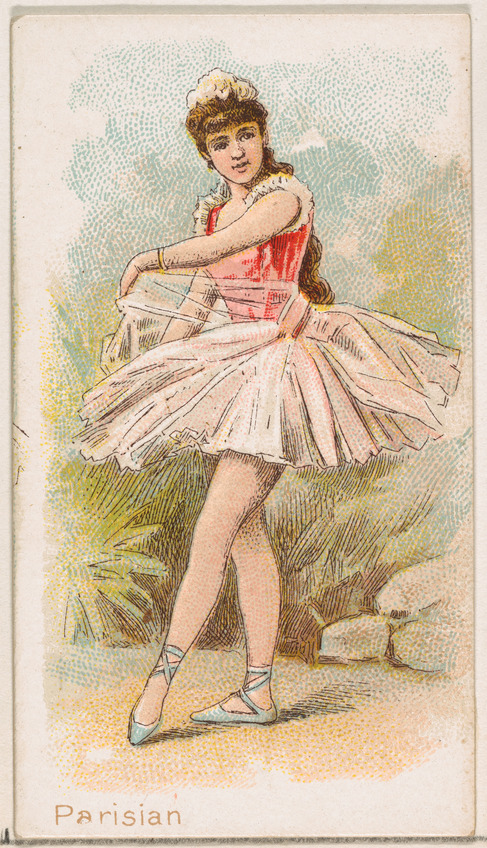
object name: print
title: Parisian Dancer, from the Dancing Women series (N186) issued by Wm. S. Kimball & Co.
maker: william s. kimball & company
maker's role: publisher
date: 1889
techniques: color lithograph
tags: women,dancing,dancers